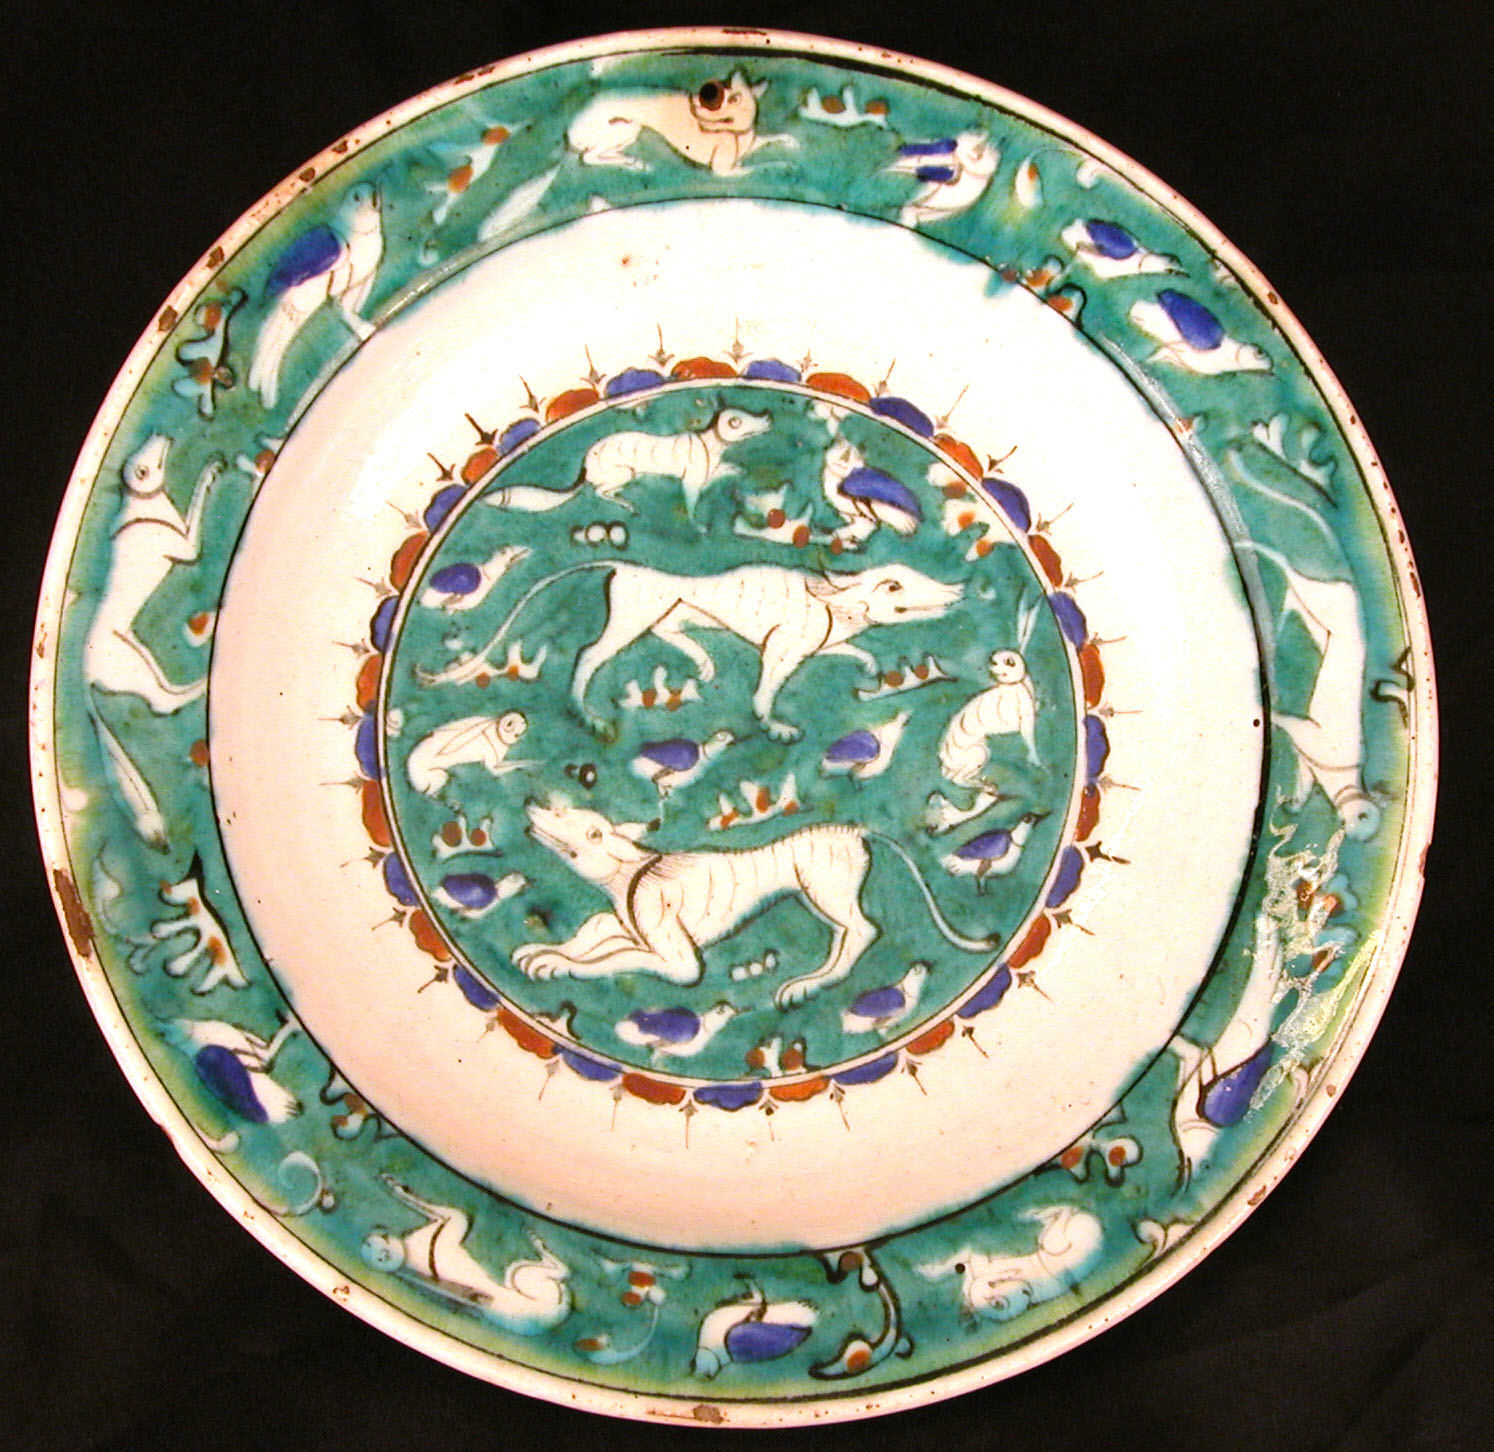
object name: dish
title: Dish with Bird, Rabbit, and Quadruped Design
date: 1576-1600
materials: glaze, stonepaste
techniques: painting, polychrome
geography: turkey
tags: animals,birds,rabbits